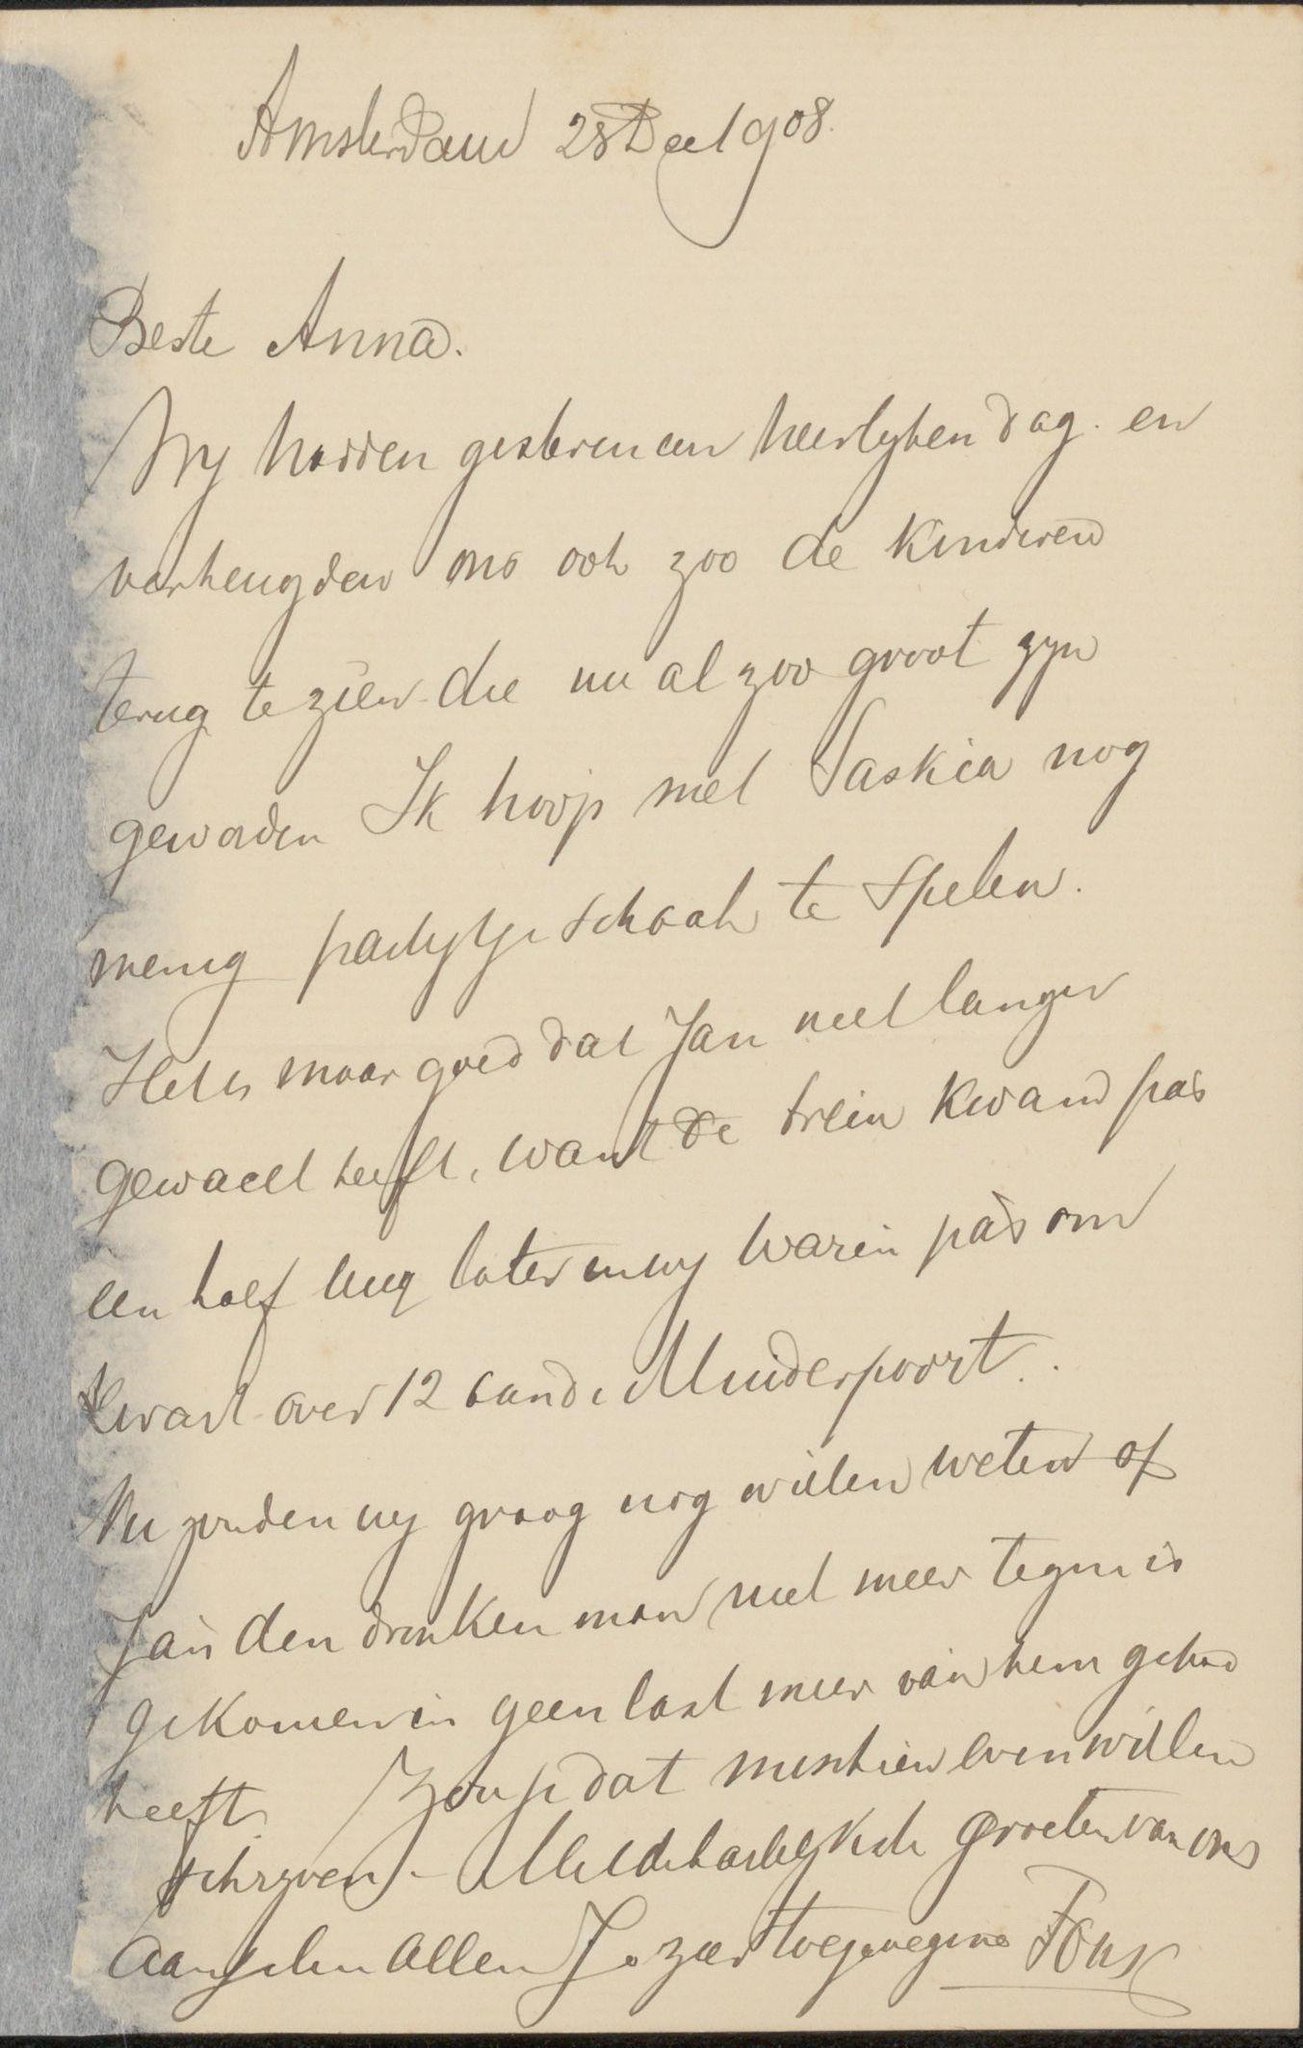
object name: letter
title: Brief aan Anna Dorothea Dirks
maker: alphons diepenbrock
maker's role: componist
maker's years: 1862-1921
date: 1908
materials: ink, paper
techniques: pen, writing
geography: amsterdam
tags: anna dorothea dirks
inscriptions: collector's mark: ‘RPK’